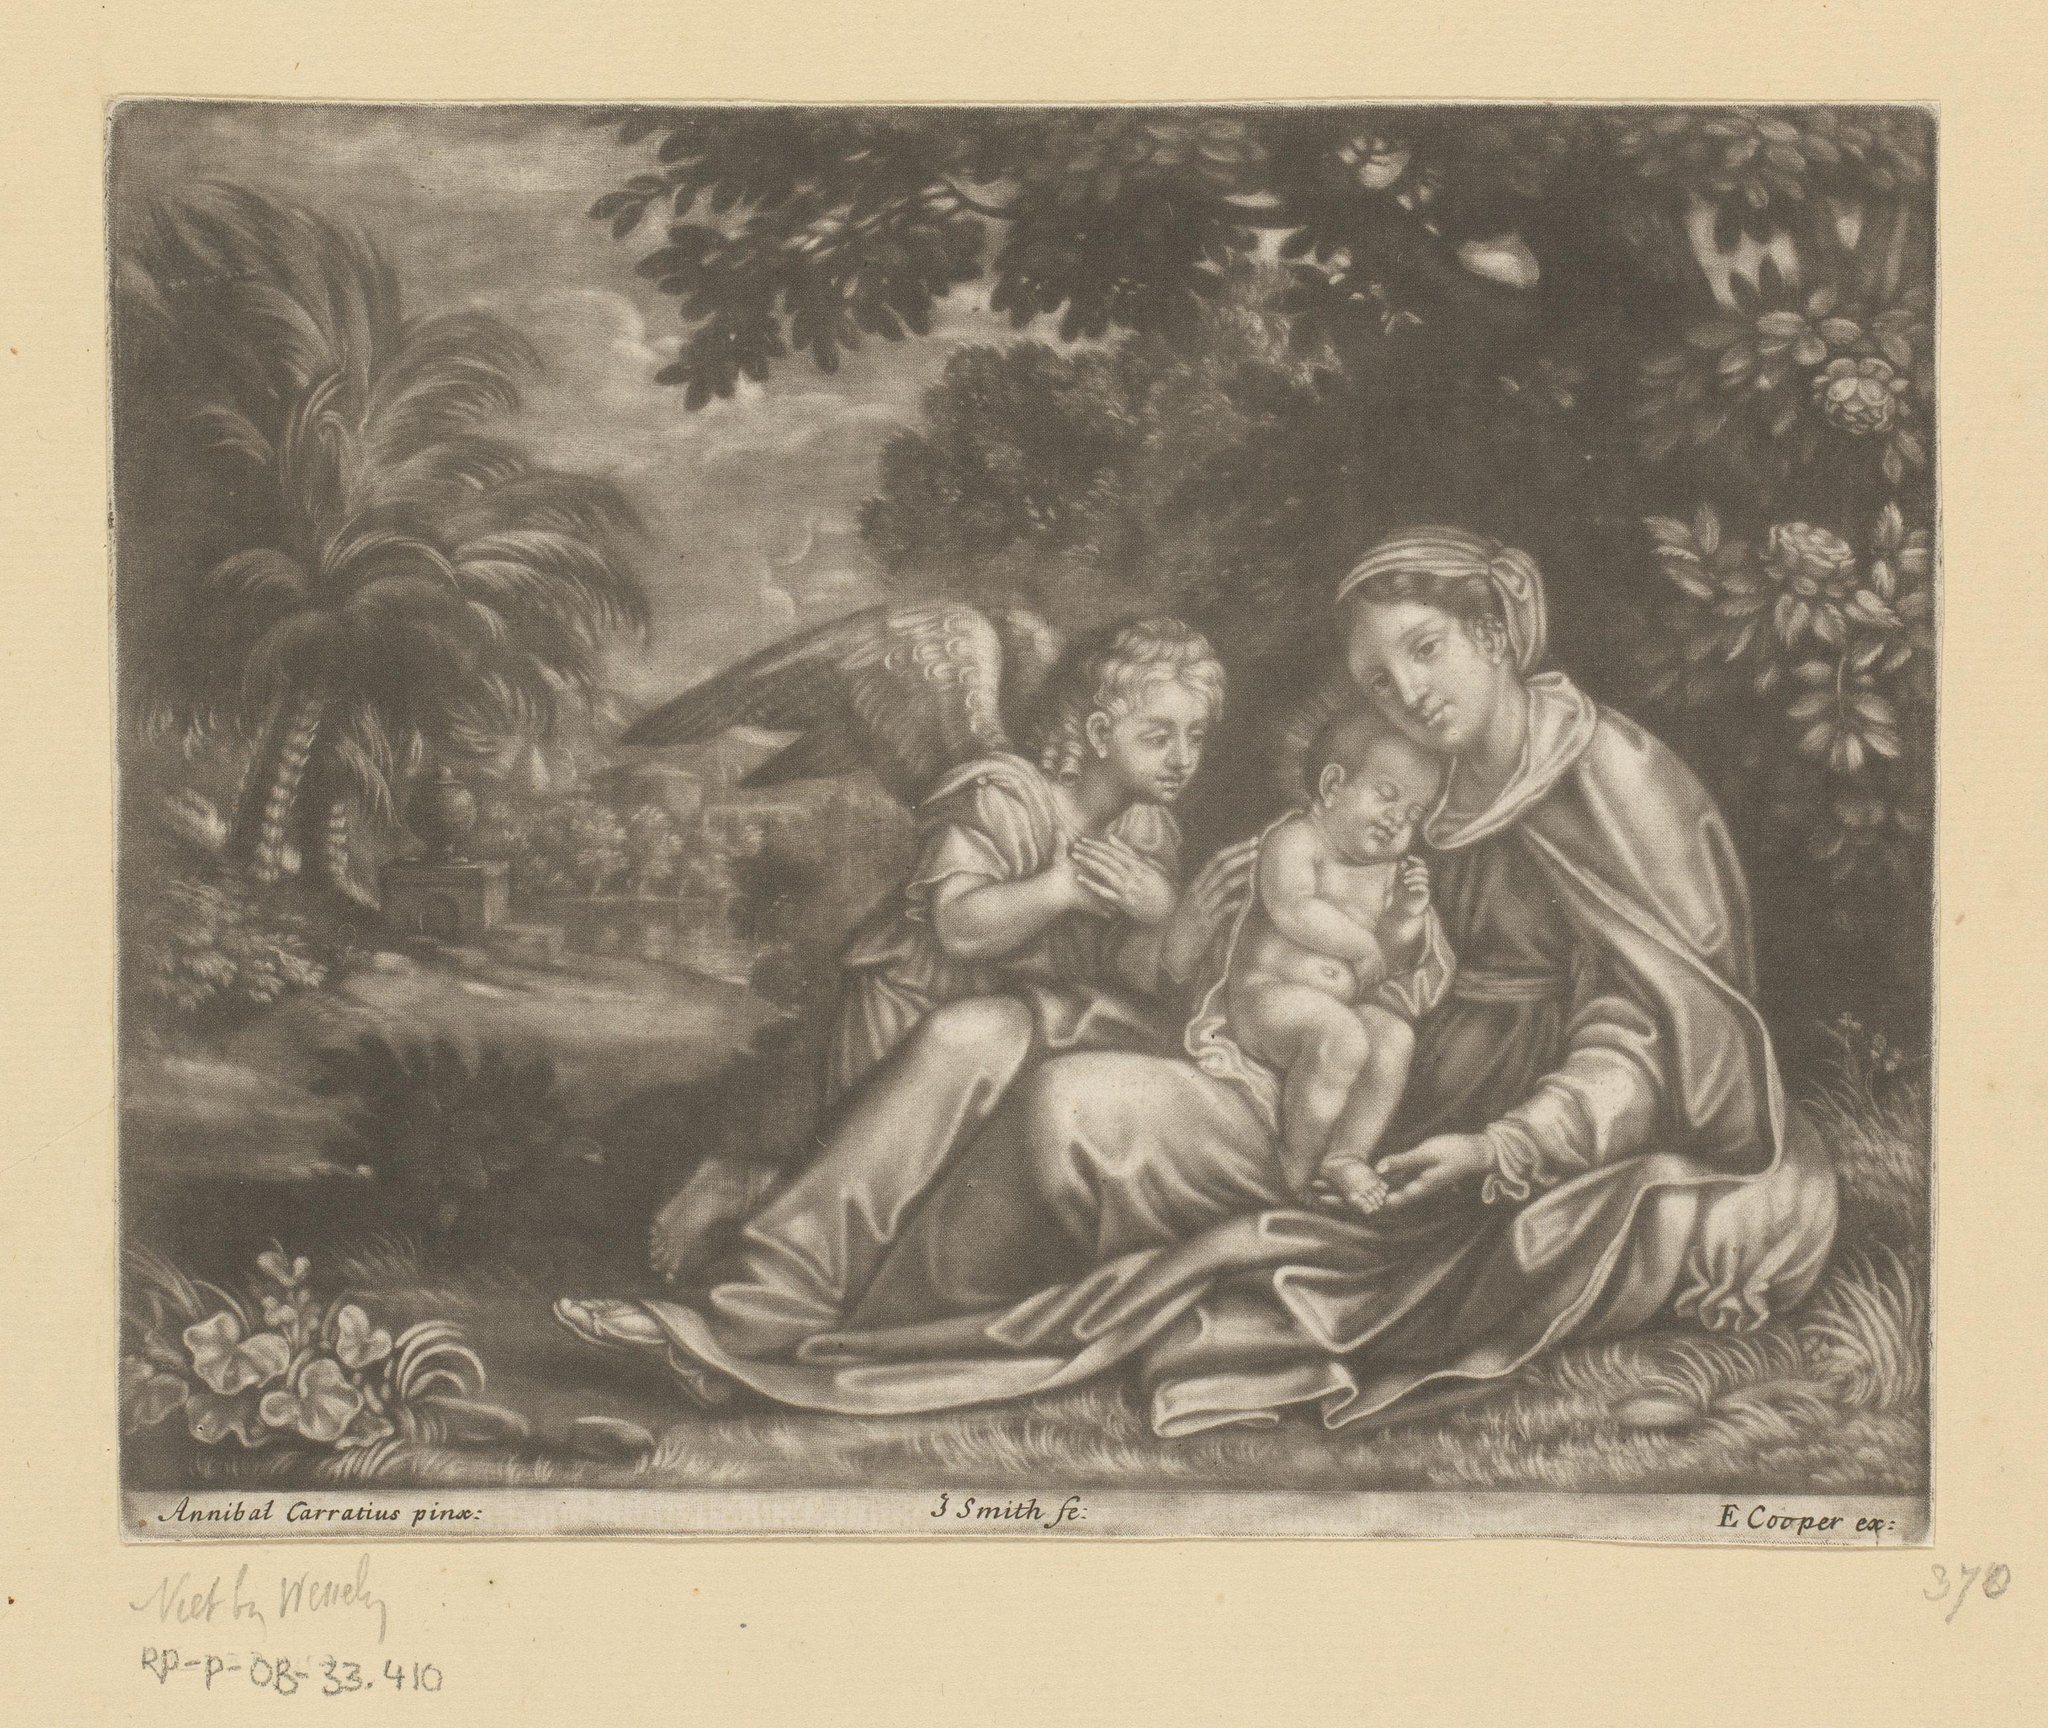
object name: print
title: Maria met Christuskind en een engel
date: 1682-1725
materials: paper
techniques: mezzotint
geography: london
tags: madonna: mary sitting on the ground, the christ-child in her lap, madonna: mary sitting on the ground, the christ-child in her lap (+ angel(s))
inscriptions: collector's mark: Lugt 240